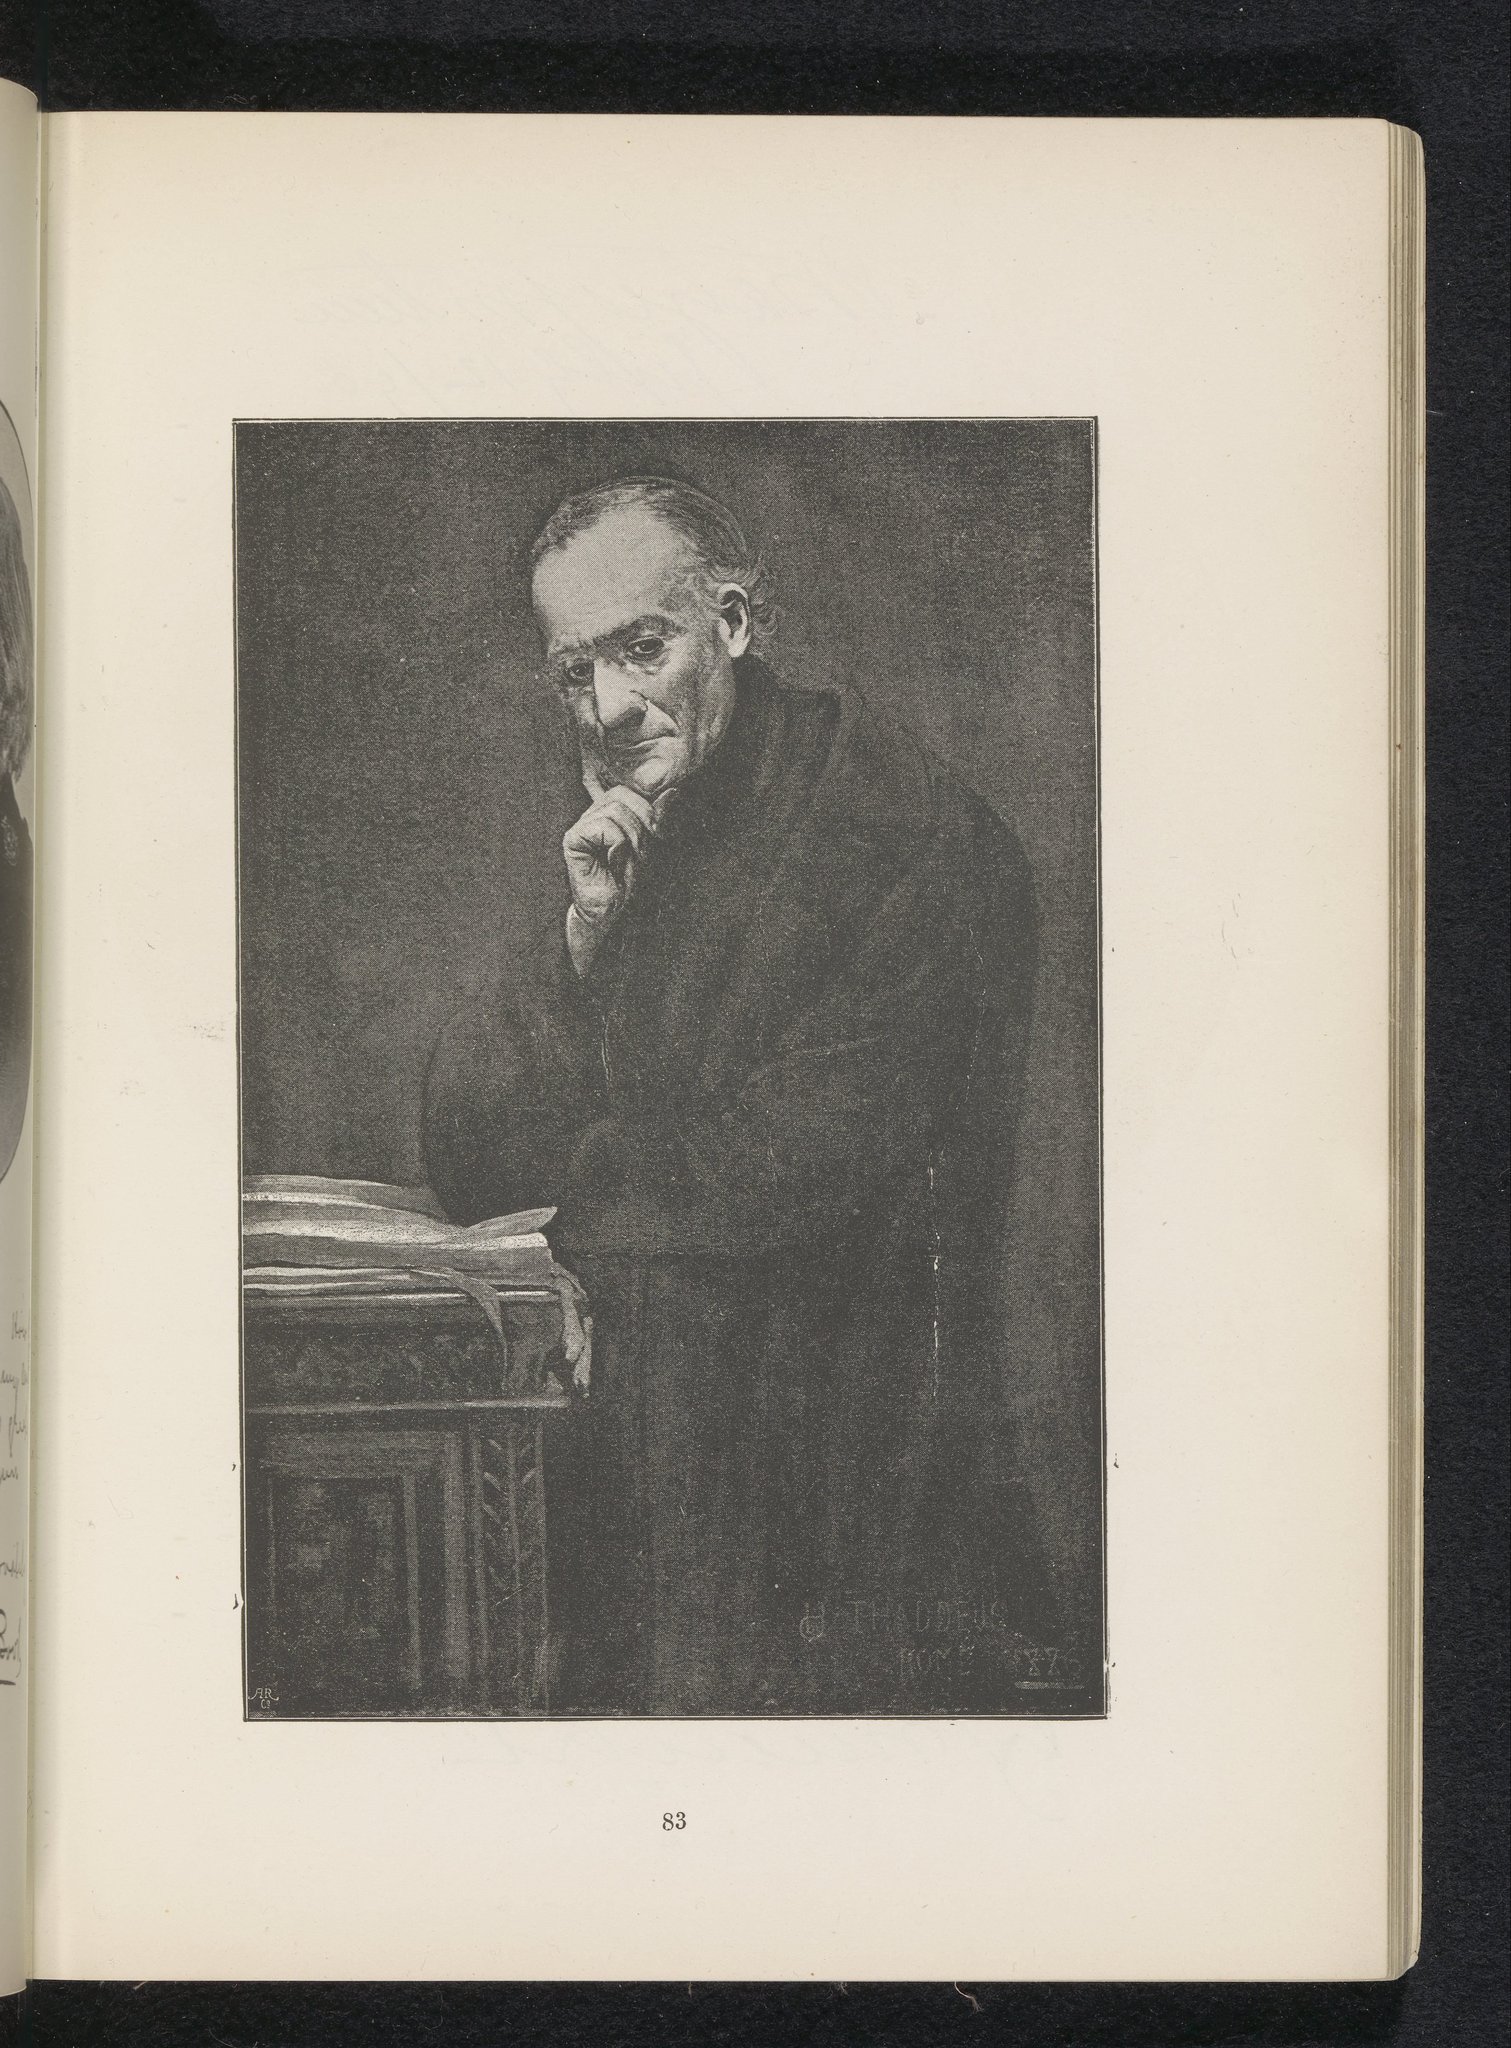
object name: page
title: Fotoreproductie van een schilderij, voorstellende een portret van Anton Anderledy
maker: Anonymous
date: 1881-1891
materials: paper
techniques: autotype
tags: theologian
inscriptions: inscription